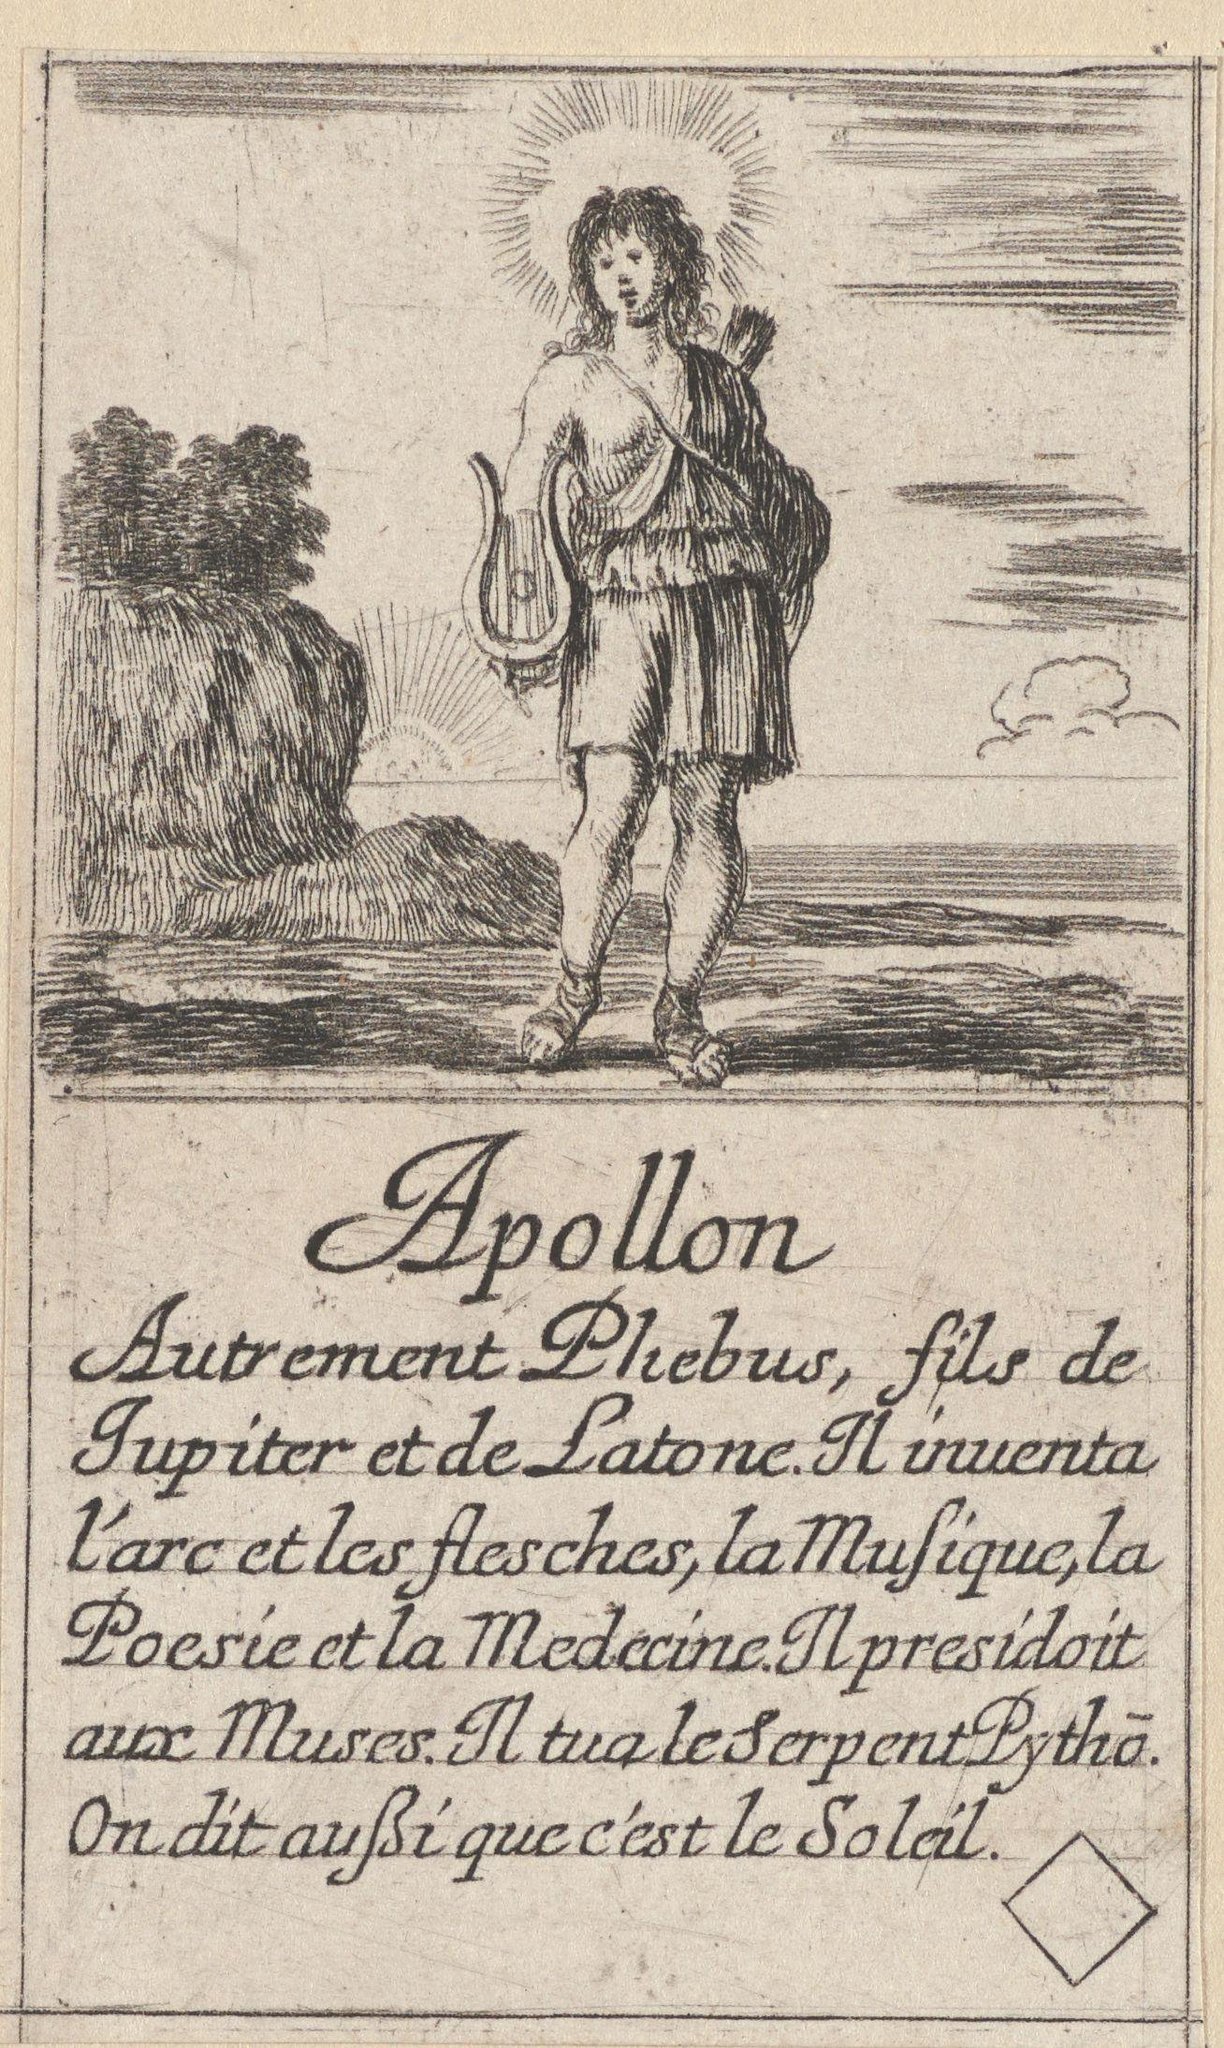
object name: playing card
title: Apollon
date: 1620-1664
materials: paper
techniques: etching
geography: paris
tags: (story of) apollo (phoebus)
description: Deze prent maakt deel uit van een kaartspel met 52 kaarten met voorstellingen uit de Metamorfosen van Ovidius. De serie is uitgedacht door Jean Desmarests de Saint-Sorlin in opdracht van Kardinaal Mazarin. Het kaartspel werd gemaakt voor de jonge Lodewijk XIV, samen met het Jeu des Reynes Renommées, Jeu de la Géographie en Jeu des Rois de France.